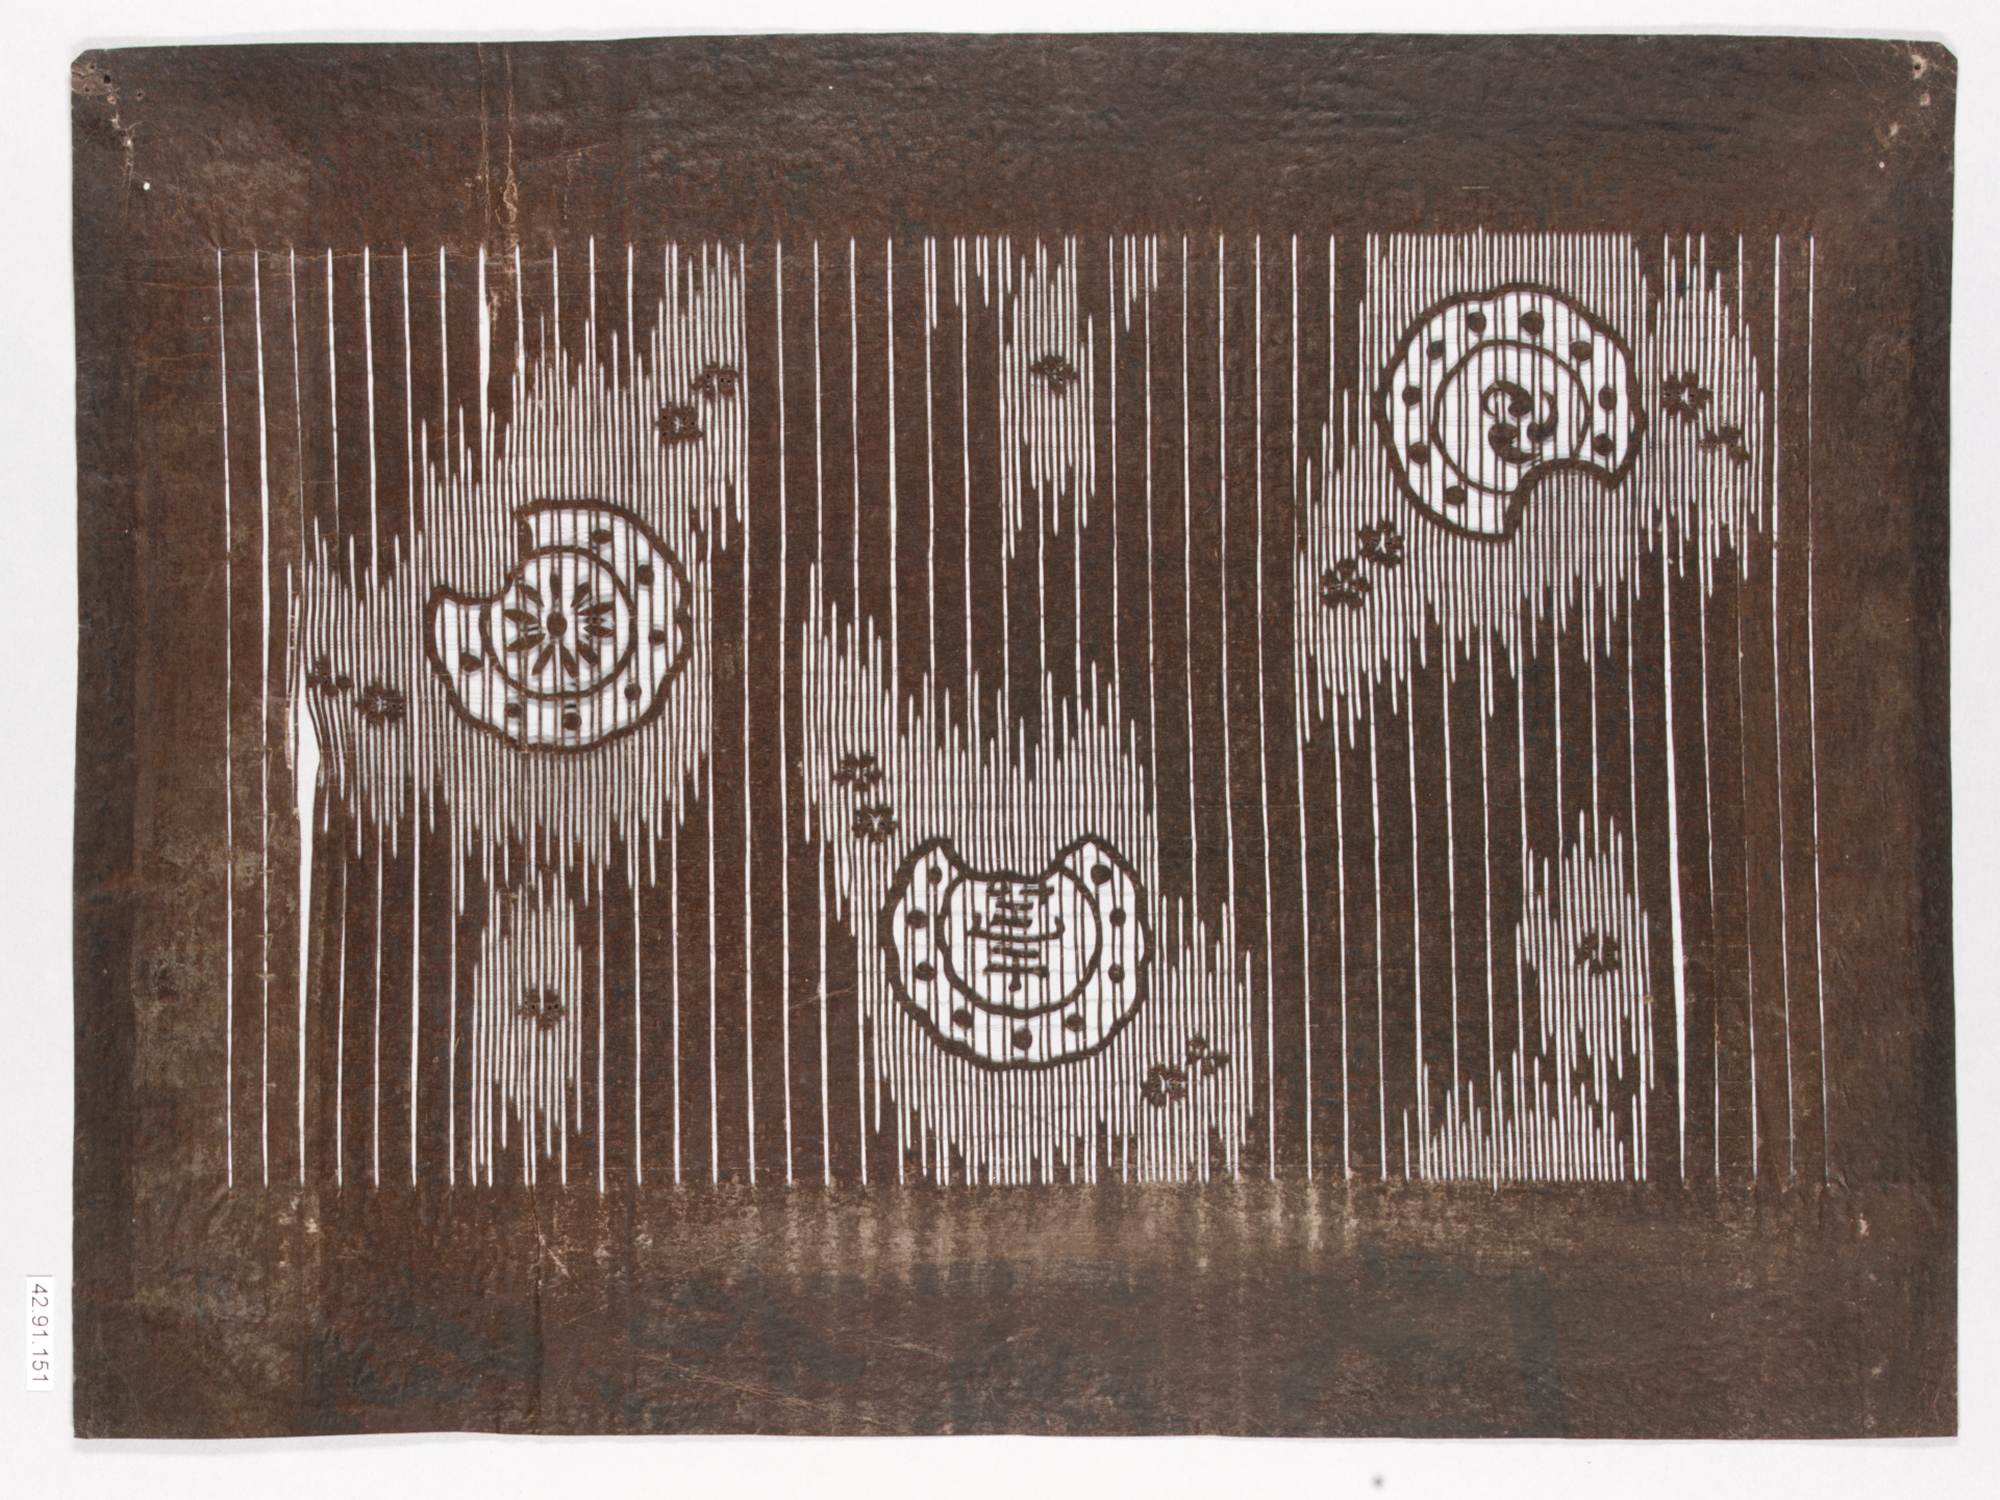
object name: stencil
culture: japanese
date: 1801-1900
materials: paper